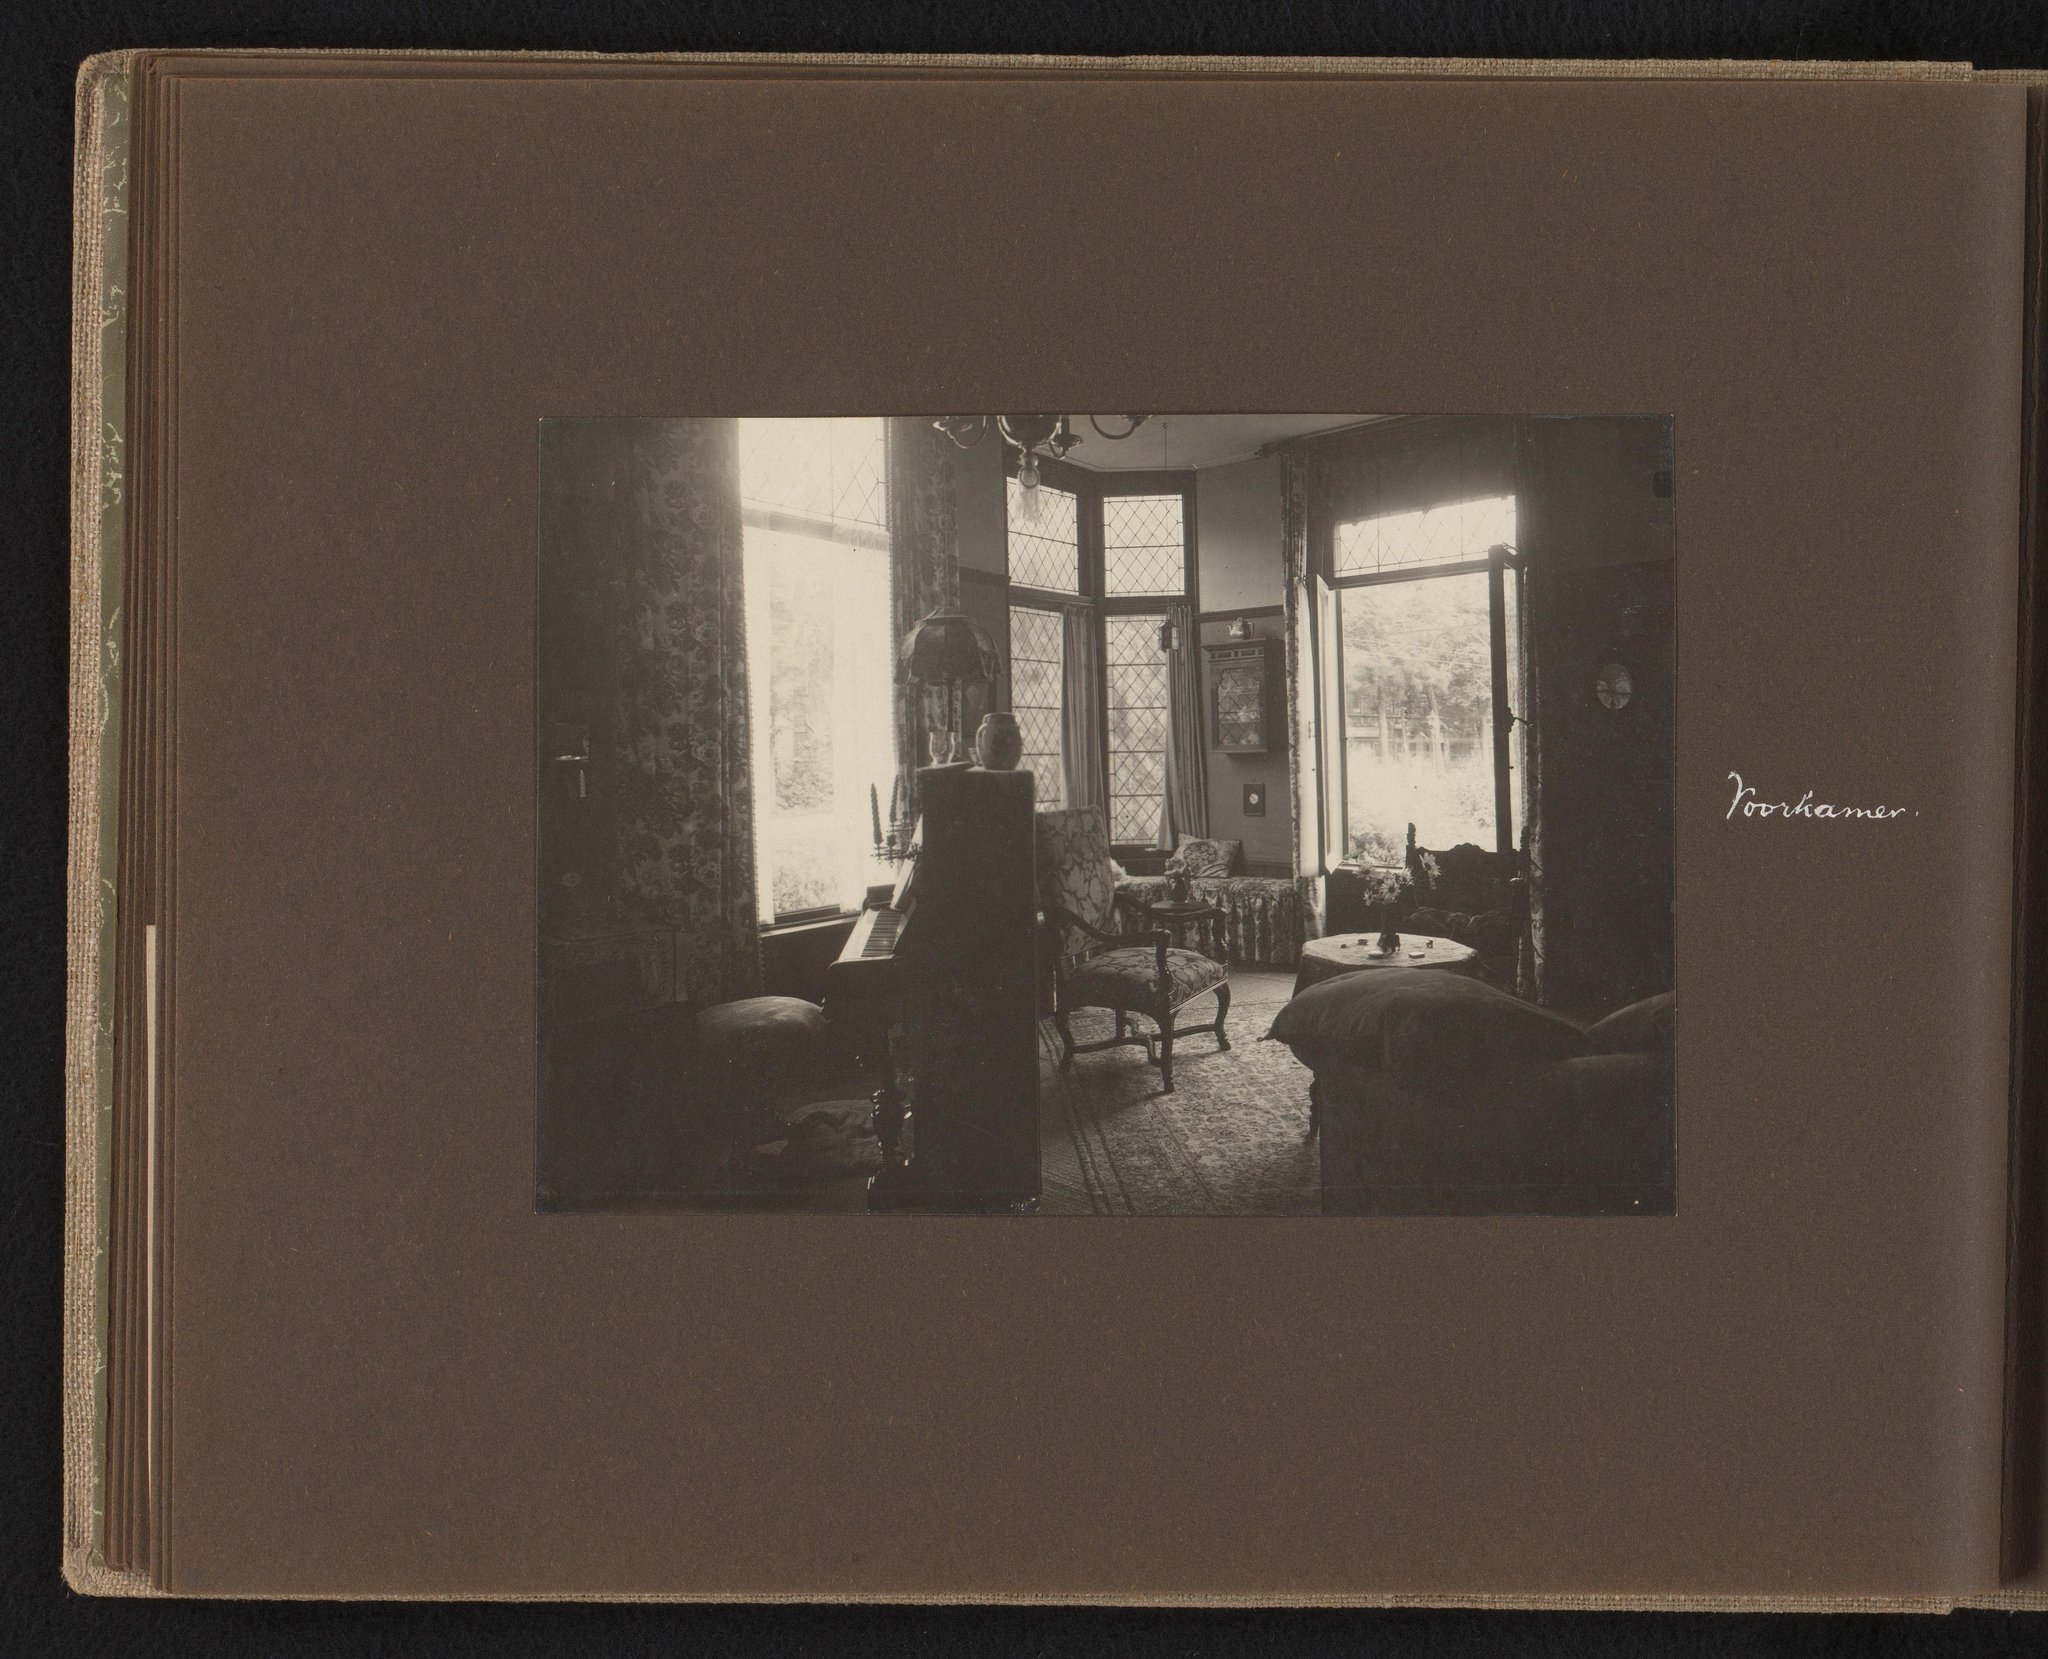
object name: album leaf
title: Interieur van de voorkamer van het Plantsoen 9B te Leiden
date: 1919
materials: paper, cardboard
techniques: gelatin silver print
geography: leiden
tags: interior of the house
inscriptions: date: ‘1919’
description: Woning van Frederik (Frits) Stokhuyzen. Op het bureau foto's van Johanna (Hans) de Jong. Deze foto maakt deel uit van een album.